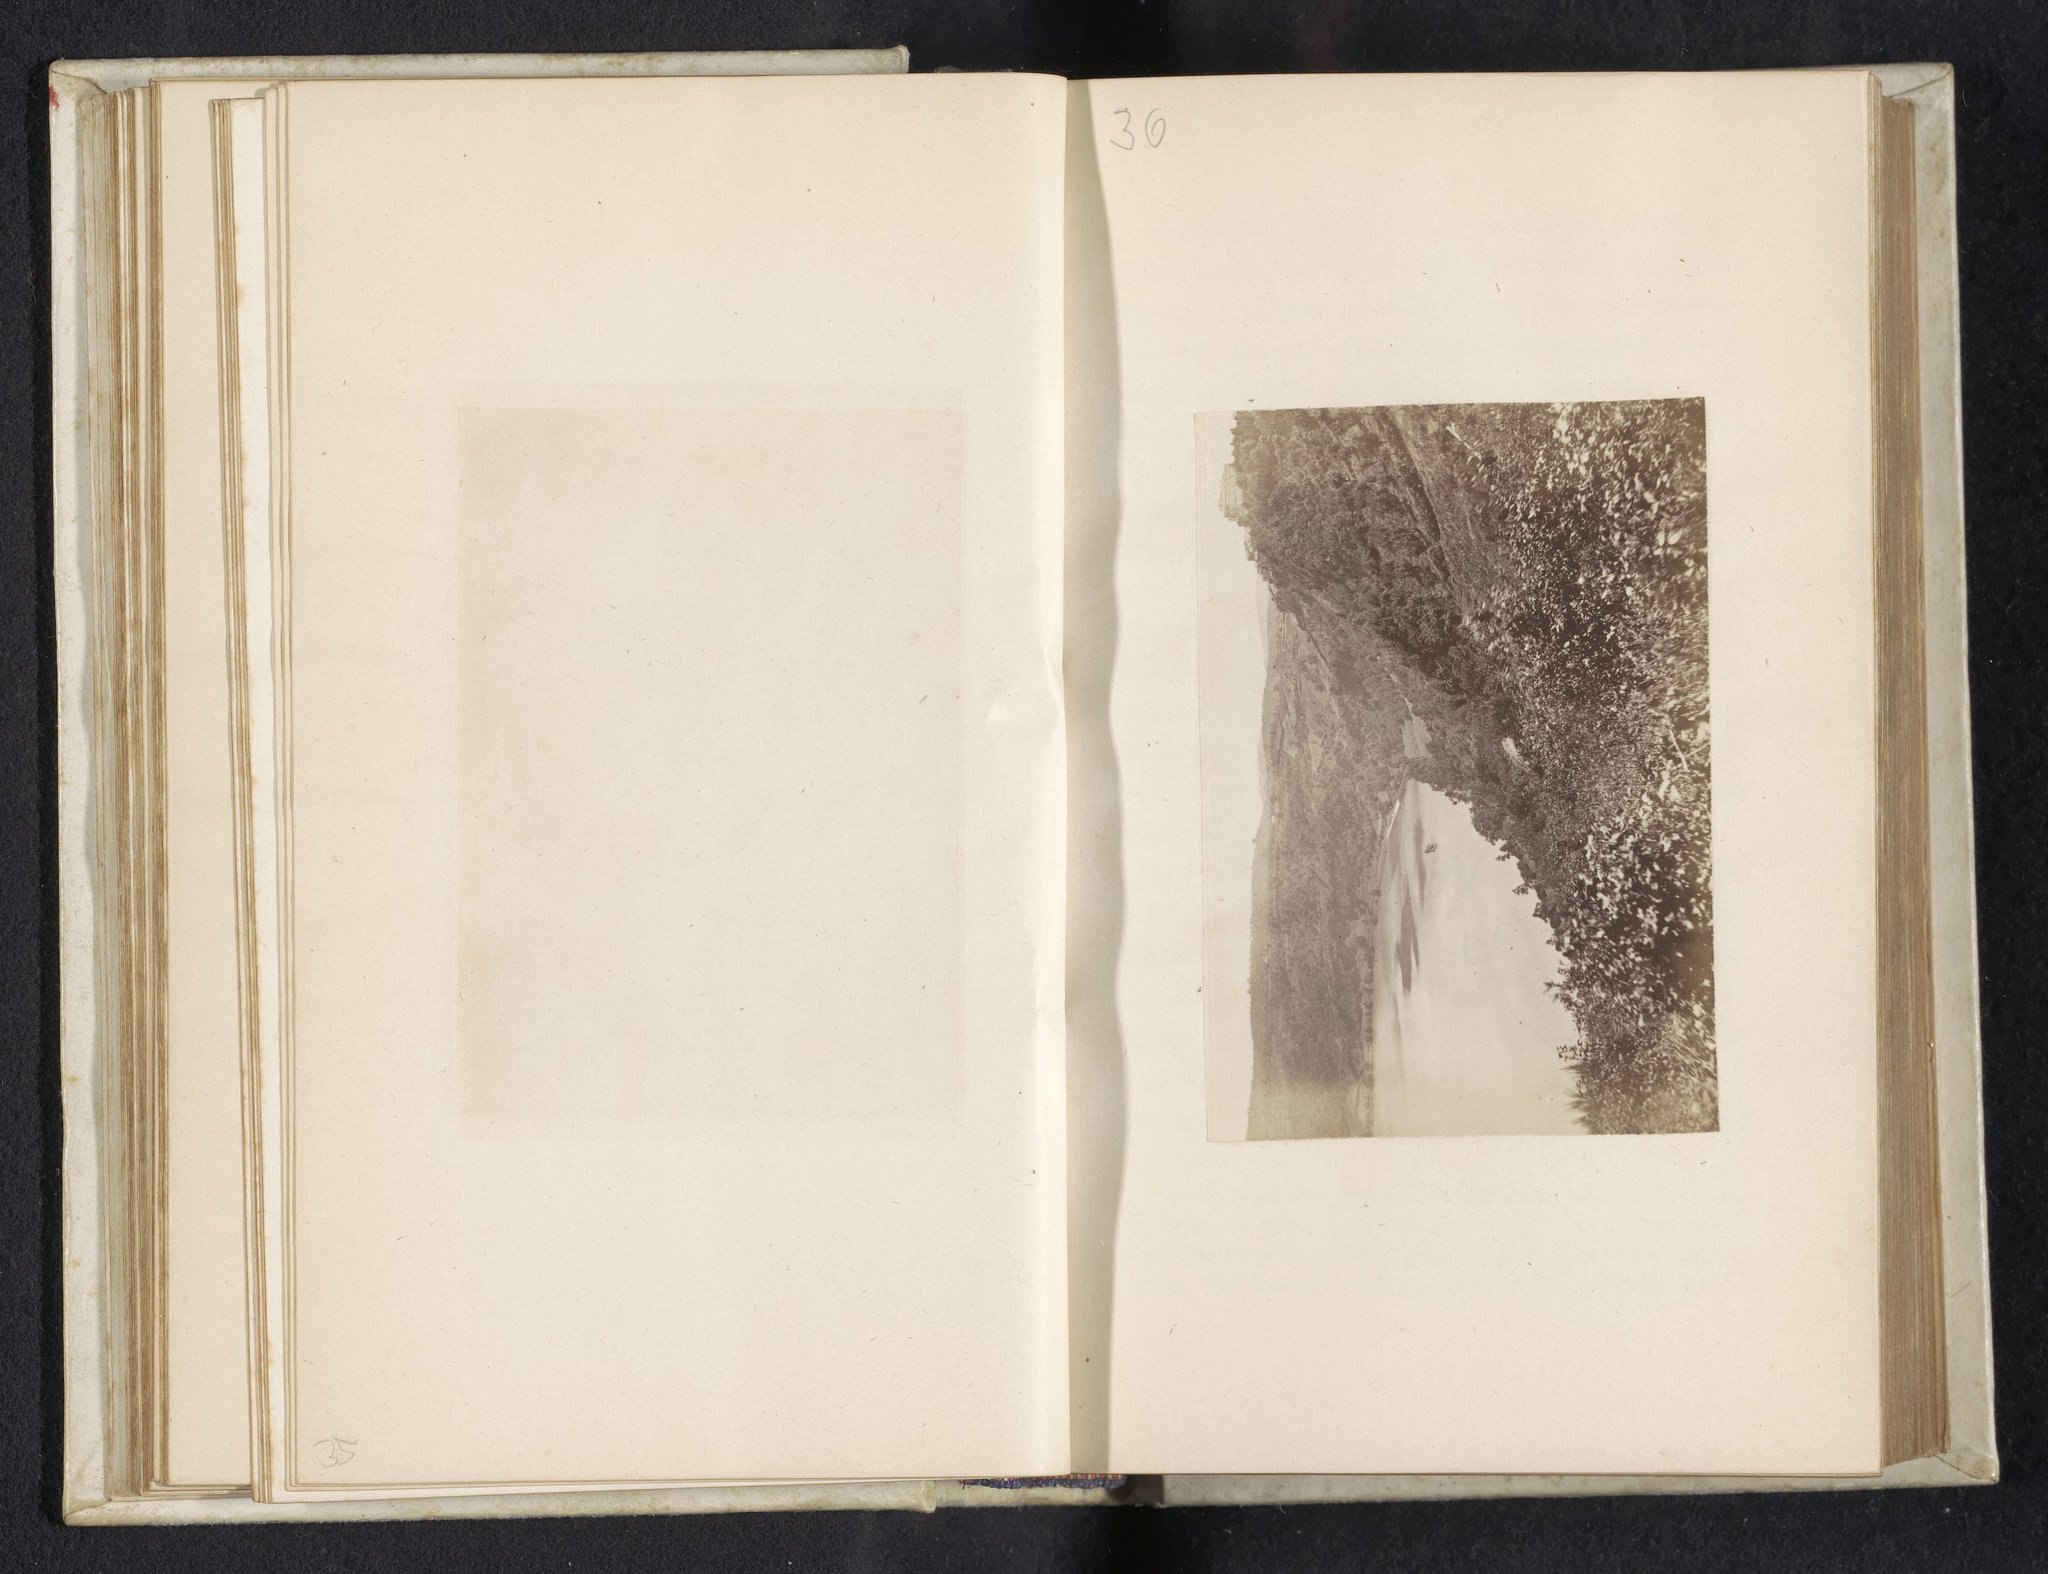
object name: page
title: Gezicht op een meer (vermoedelijk) te Italië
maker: Anonymous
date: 1850-1860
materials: photographic support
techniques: albumen print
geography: italy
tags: lake